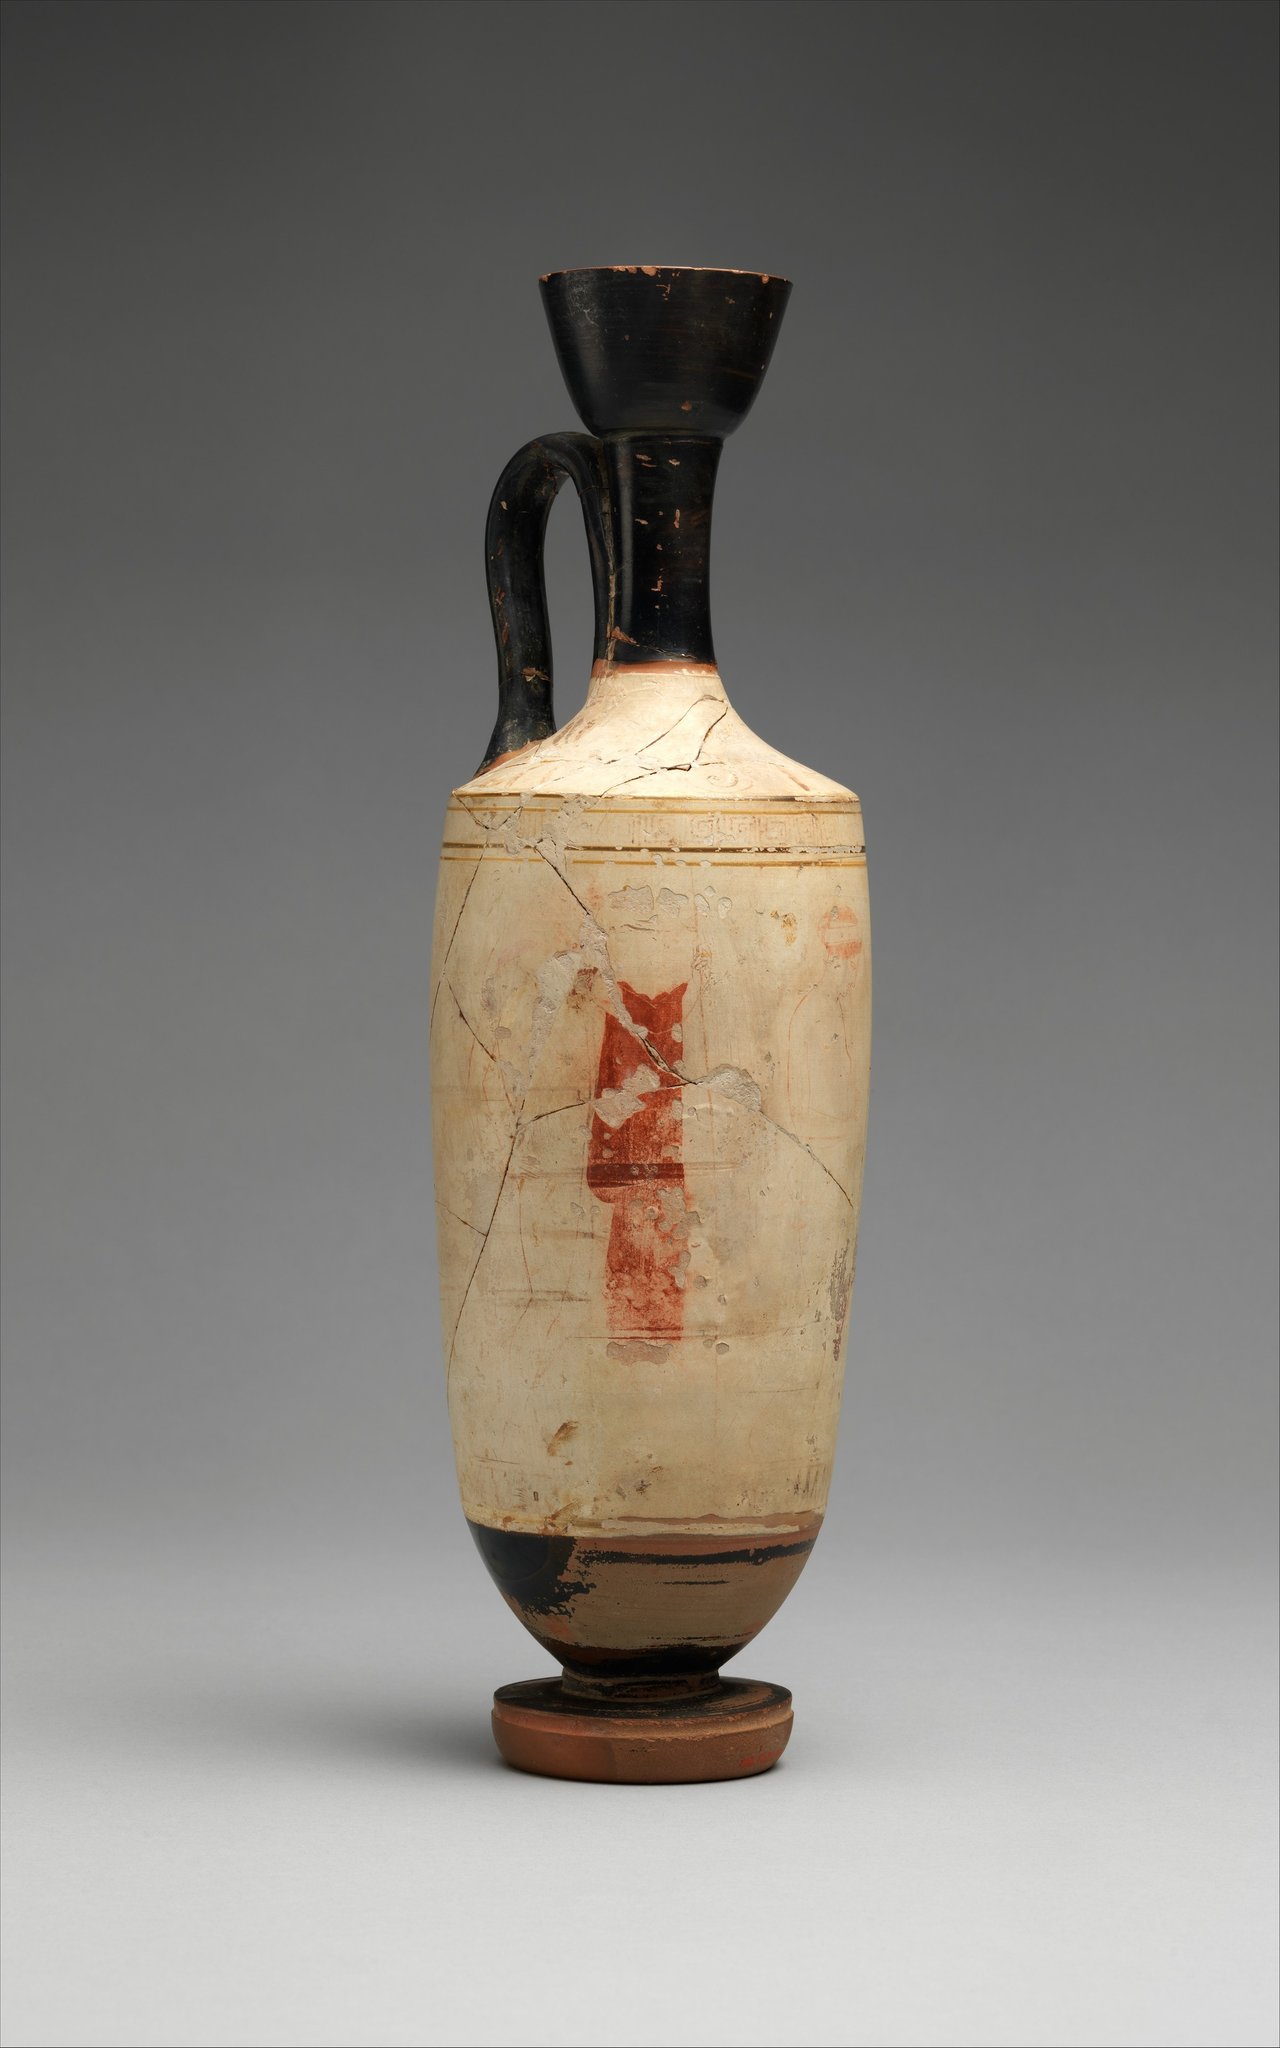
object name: lekythos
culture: greek, attic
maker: quadrate painter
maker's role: artist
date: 420 BCE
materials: terracotta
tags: women